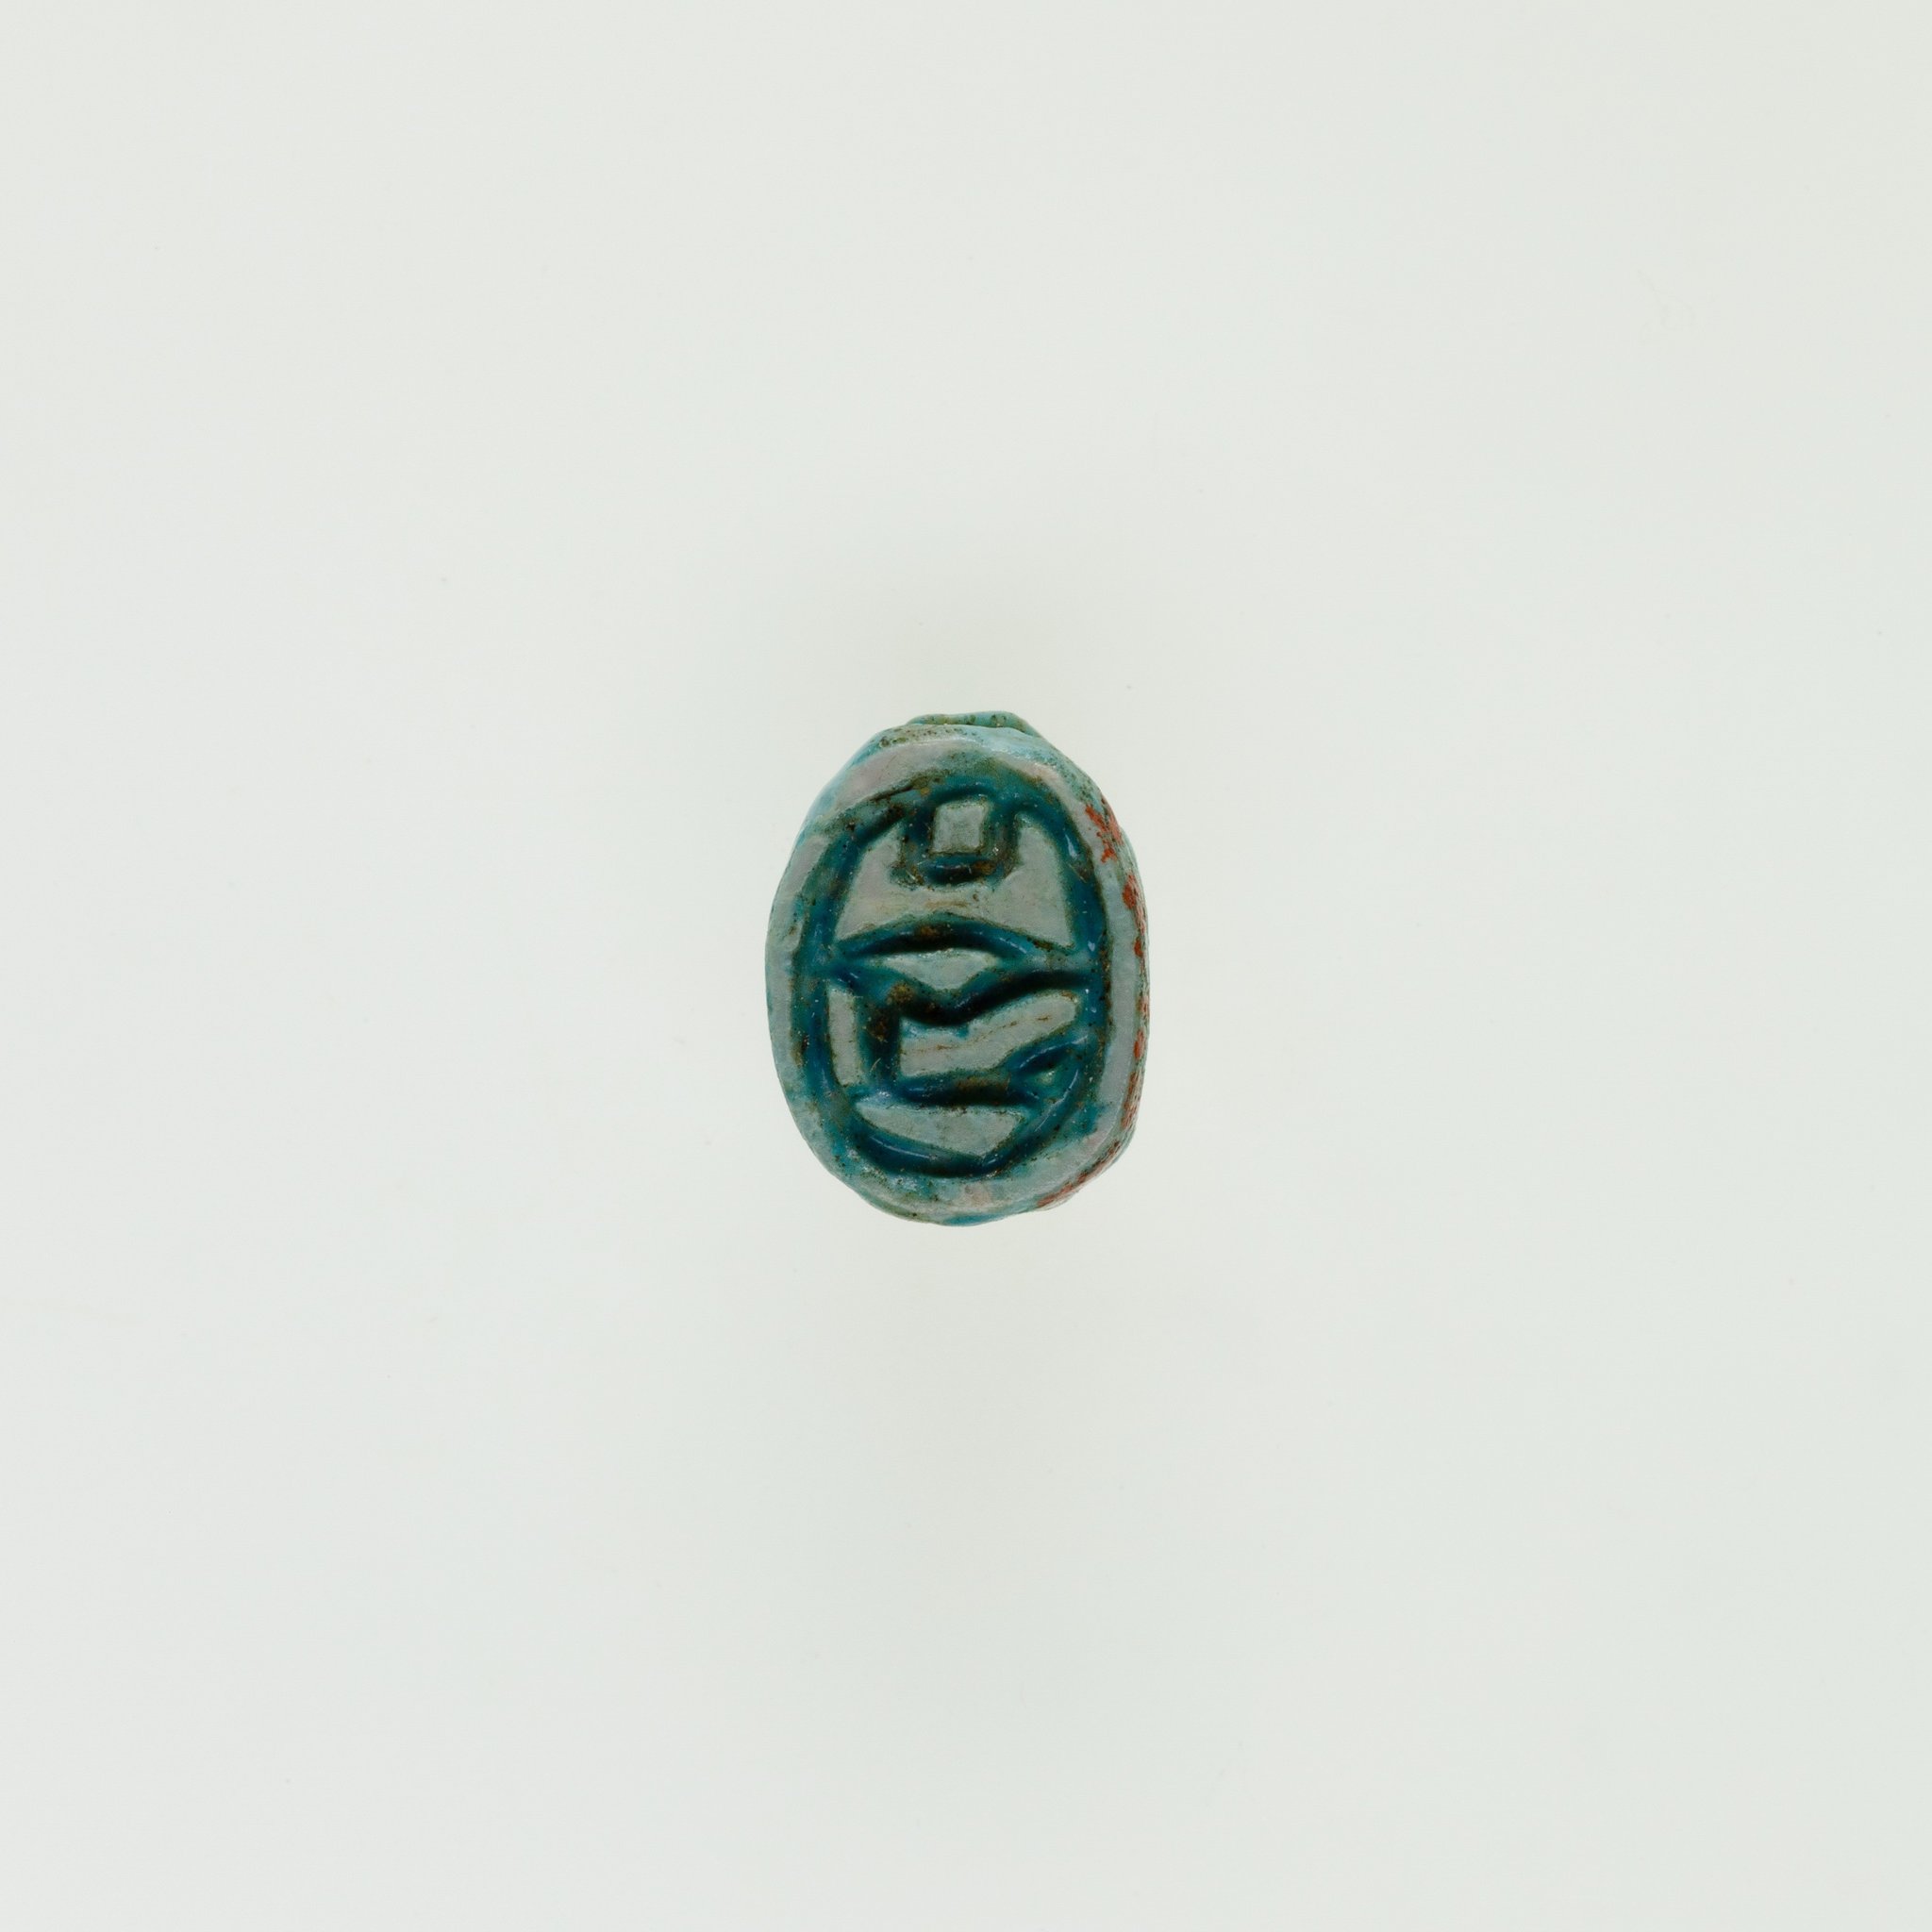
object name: scarab, hieroglyph, re, rdi ra formula, re give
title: Scarab Inscribed with a Blessing Related to Re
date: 1740-1640 BCE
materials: stone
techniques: glazing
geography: egypt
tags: scarabs